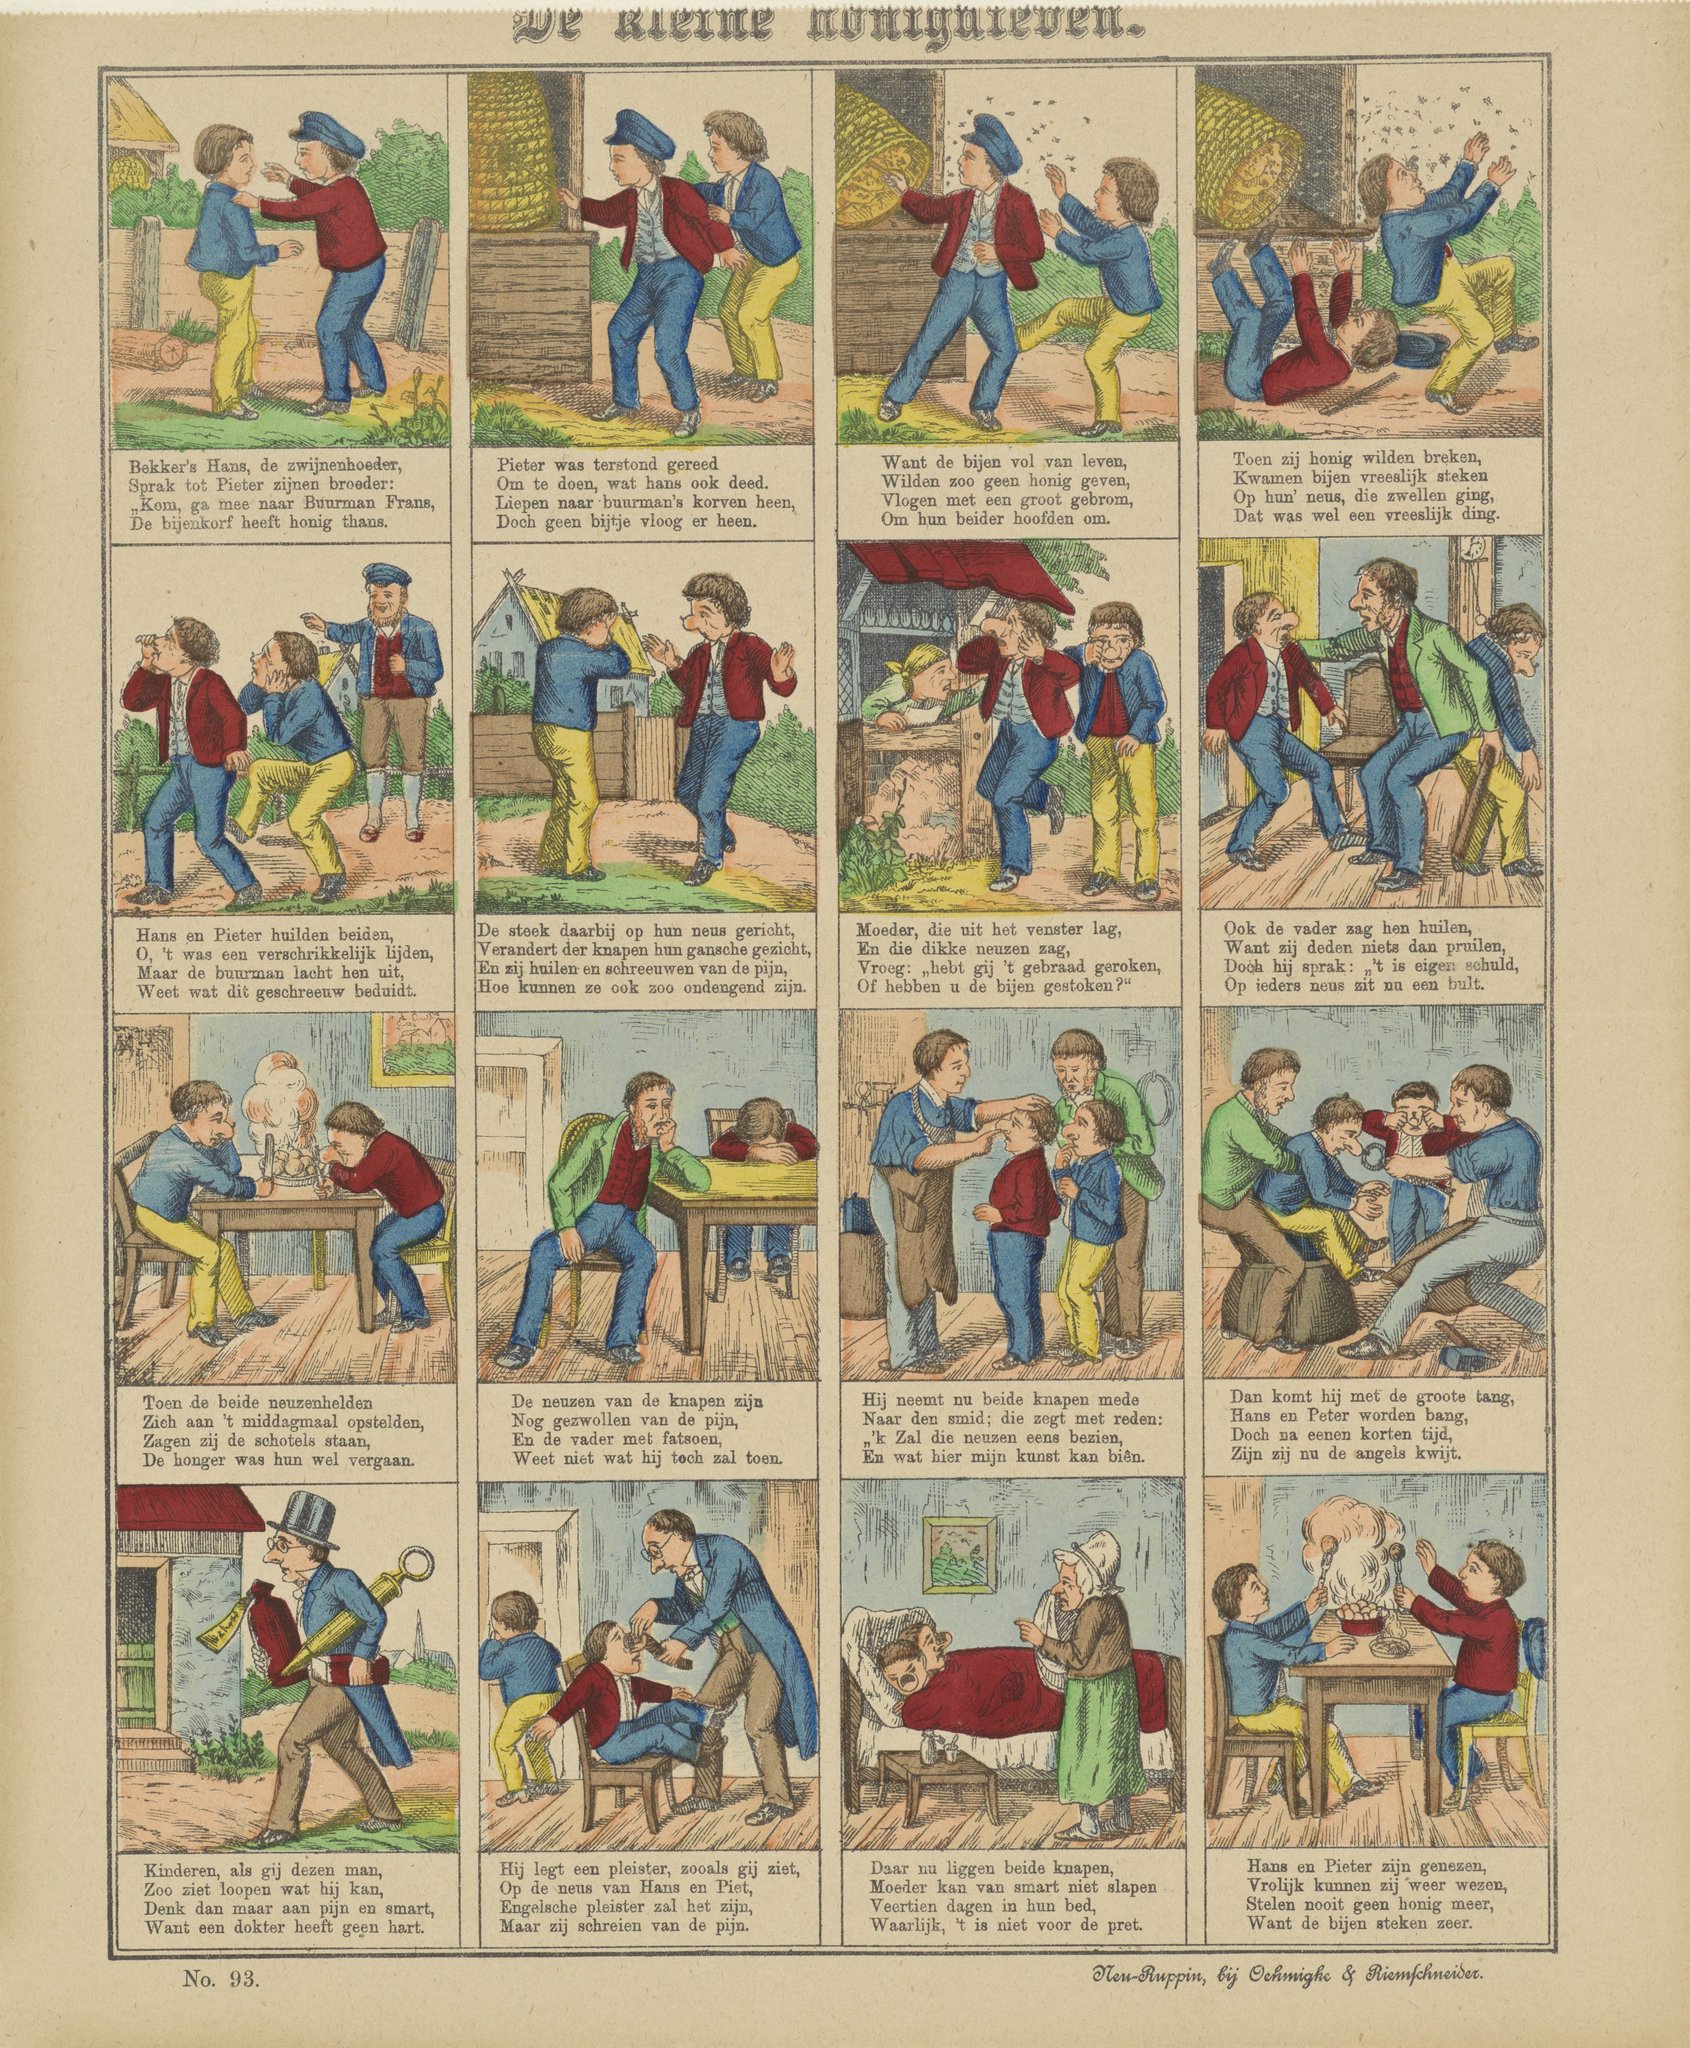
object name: popular print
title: De kleine honigdieven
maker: Anonymous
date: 1828-1937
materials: paper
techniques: hand coloring, letterpress printing, lithograph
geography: neuruppin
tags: bee-hive, tales and fairy tales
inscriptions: collector's mark: Lugt 2760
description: Blad met 16 voorstellingen uit het het verhaal van de twee deugnieten Hans en Pieter die honing stelen en vervolgens gestoken worden door bijen. Onder elke afbeelding een onderschrift. Genummerd linksonder: No. 93.